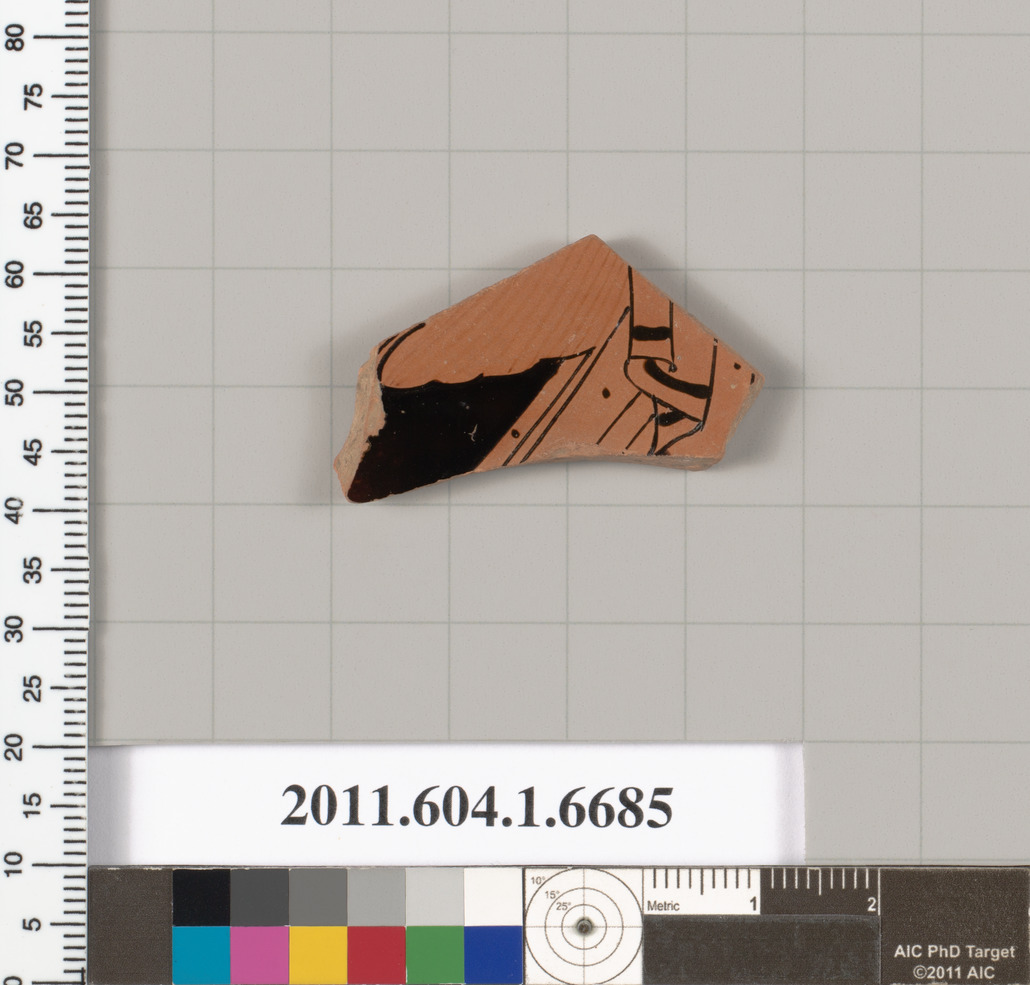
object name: kylix fragment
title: Terracotta fragment of a kylix (drinking cup)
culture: greek, attic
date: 490-470 BCE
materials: terracotta